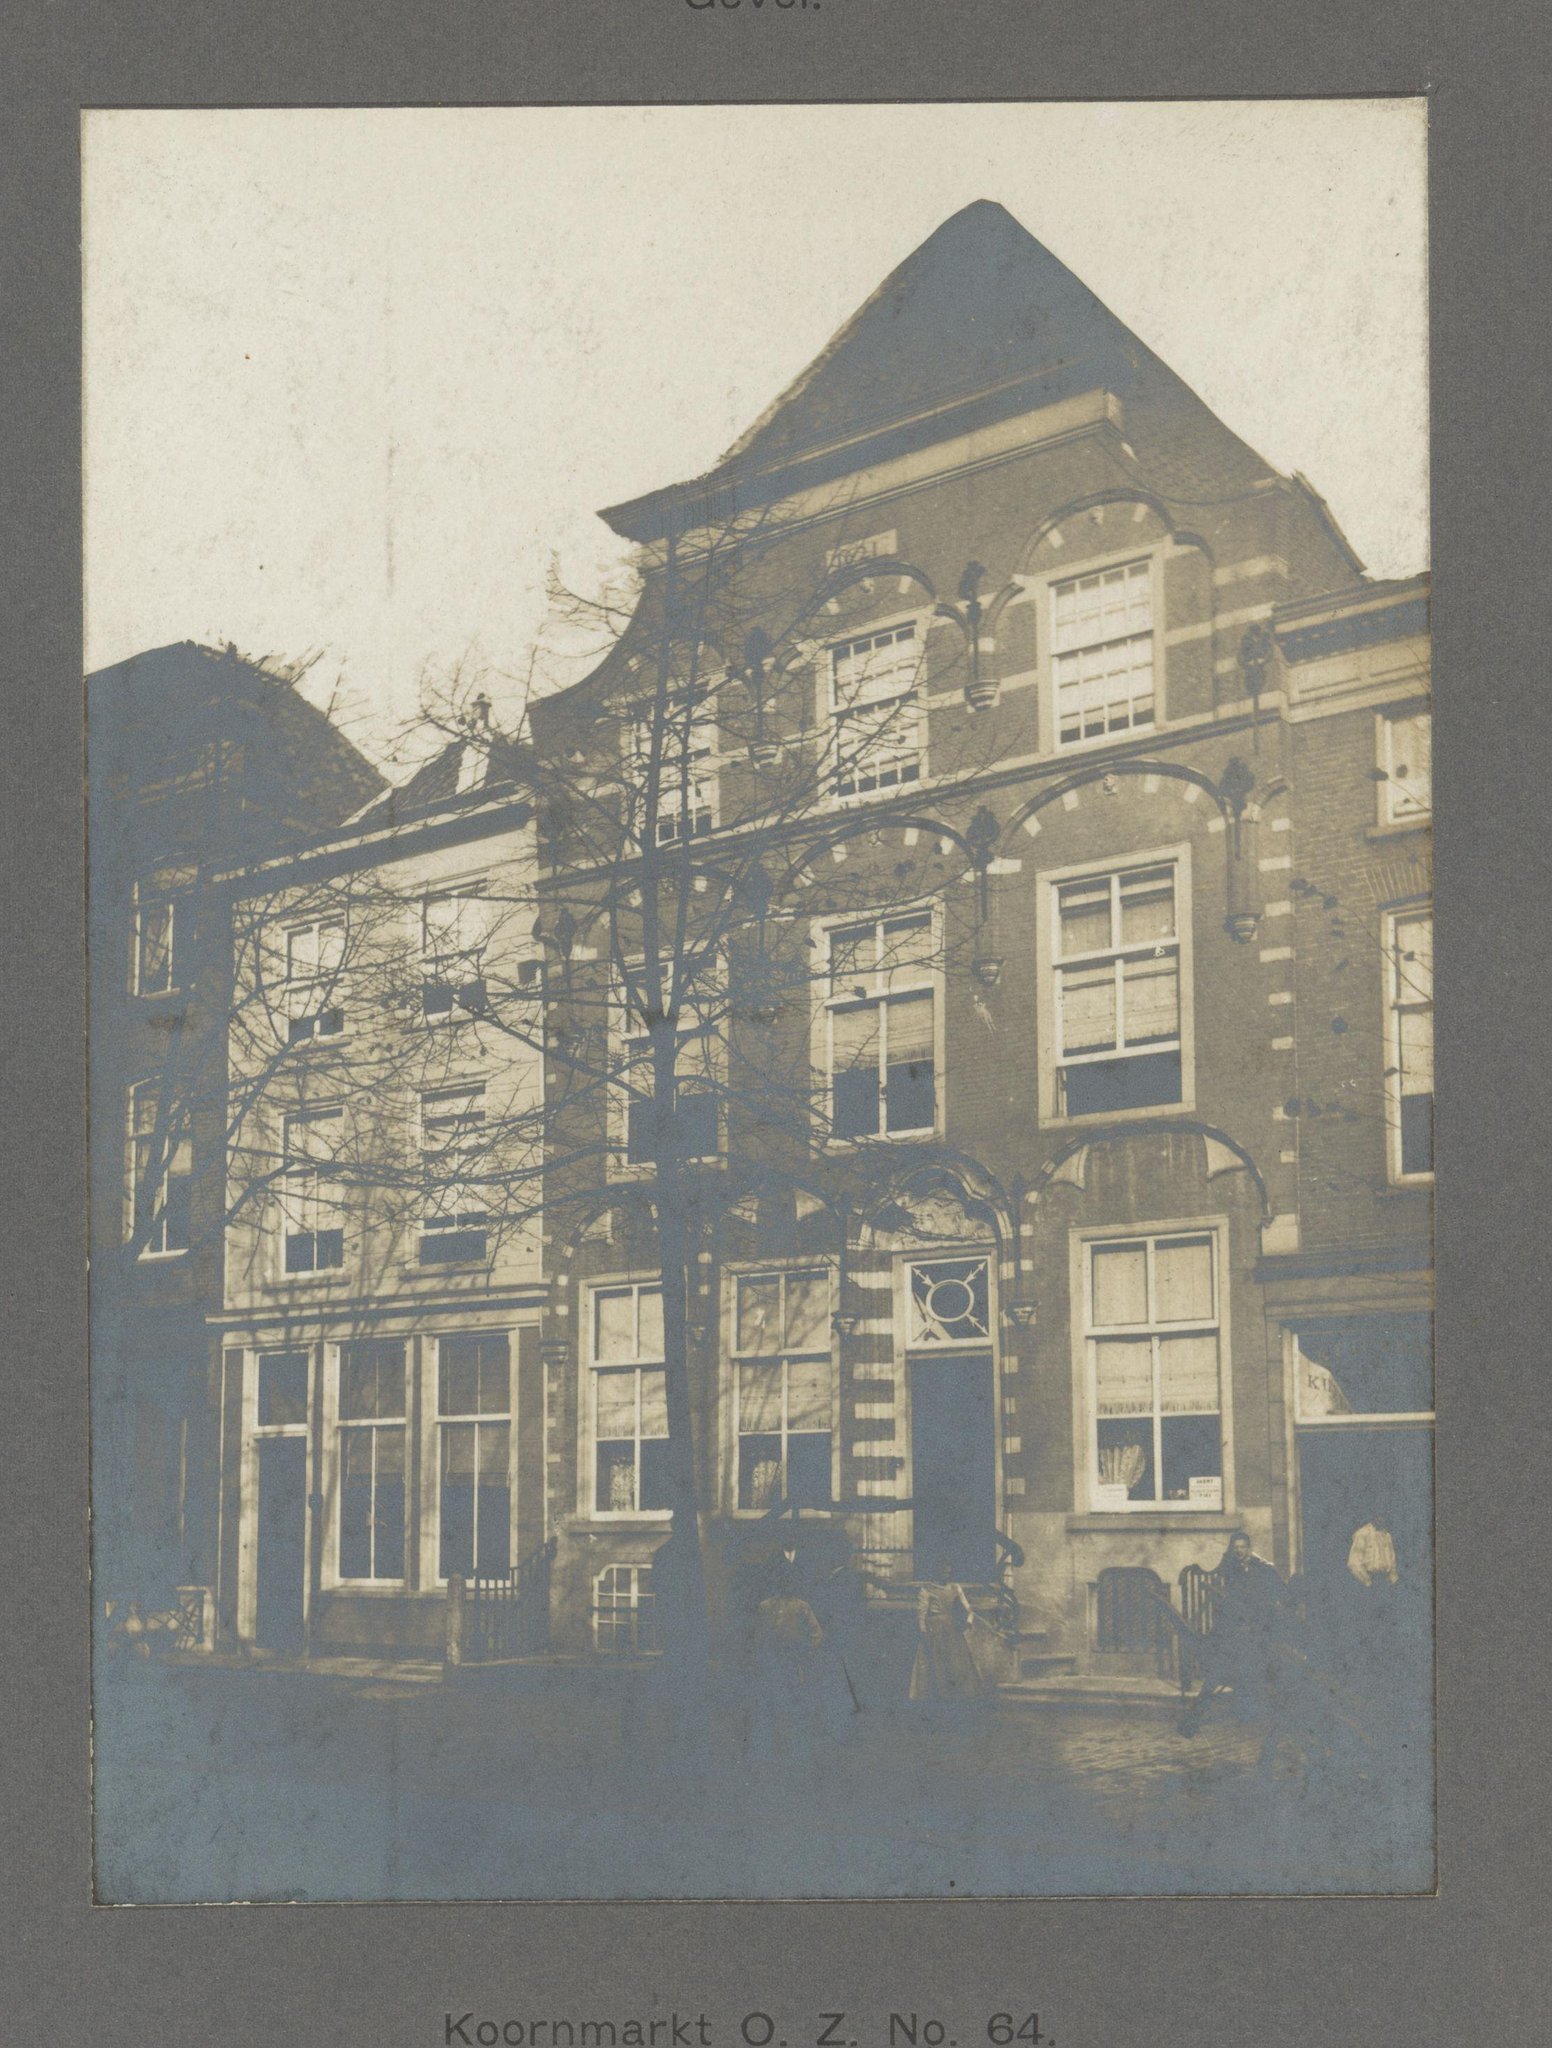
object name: photograph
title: Koornmarkt O.Z. No. 64. Gevel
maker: Anonymous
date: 1900-1904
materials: cardboard, photographic support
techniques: gelatin silver print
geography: delft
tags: urban housing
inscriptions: number: ‘34’, inscription: ‘Delft. 1545. Bovendeel veranderd 1621.’, inscription: ‘Het recht van reproductie dezer photo's wordt door den Uitgever voorbehouden.’